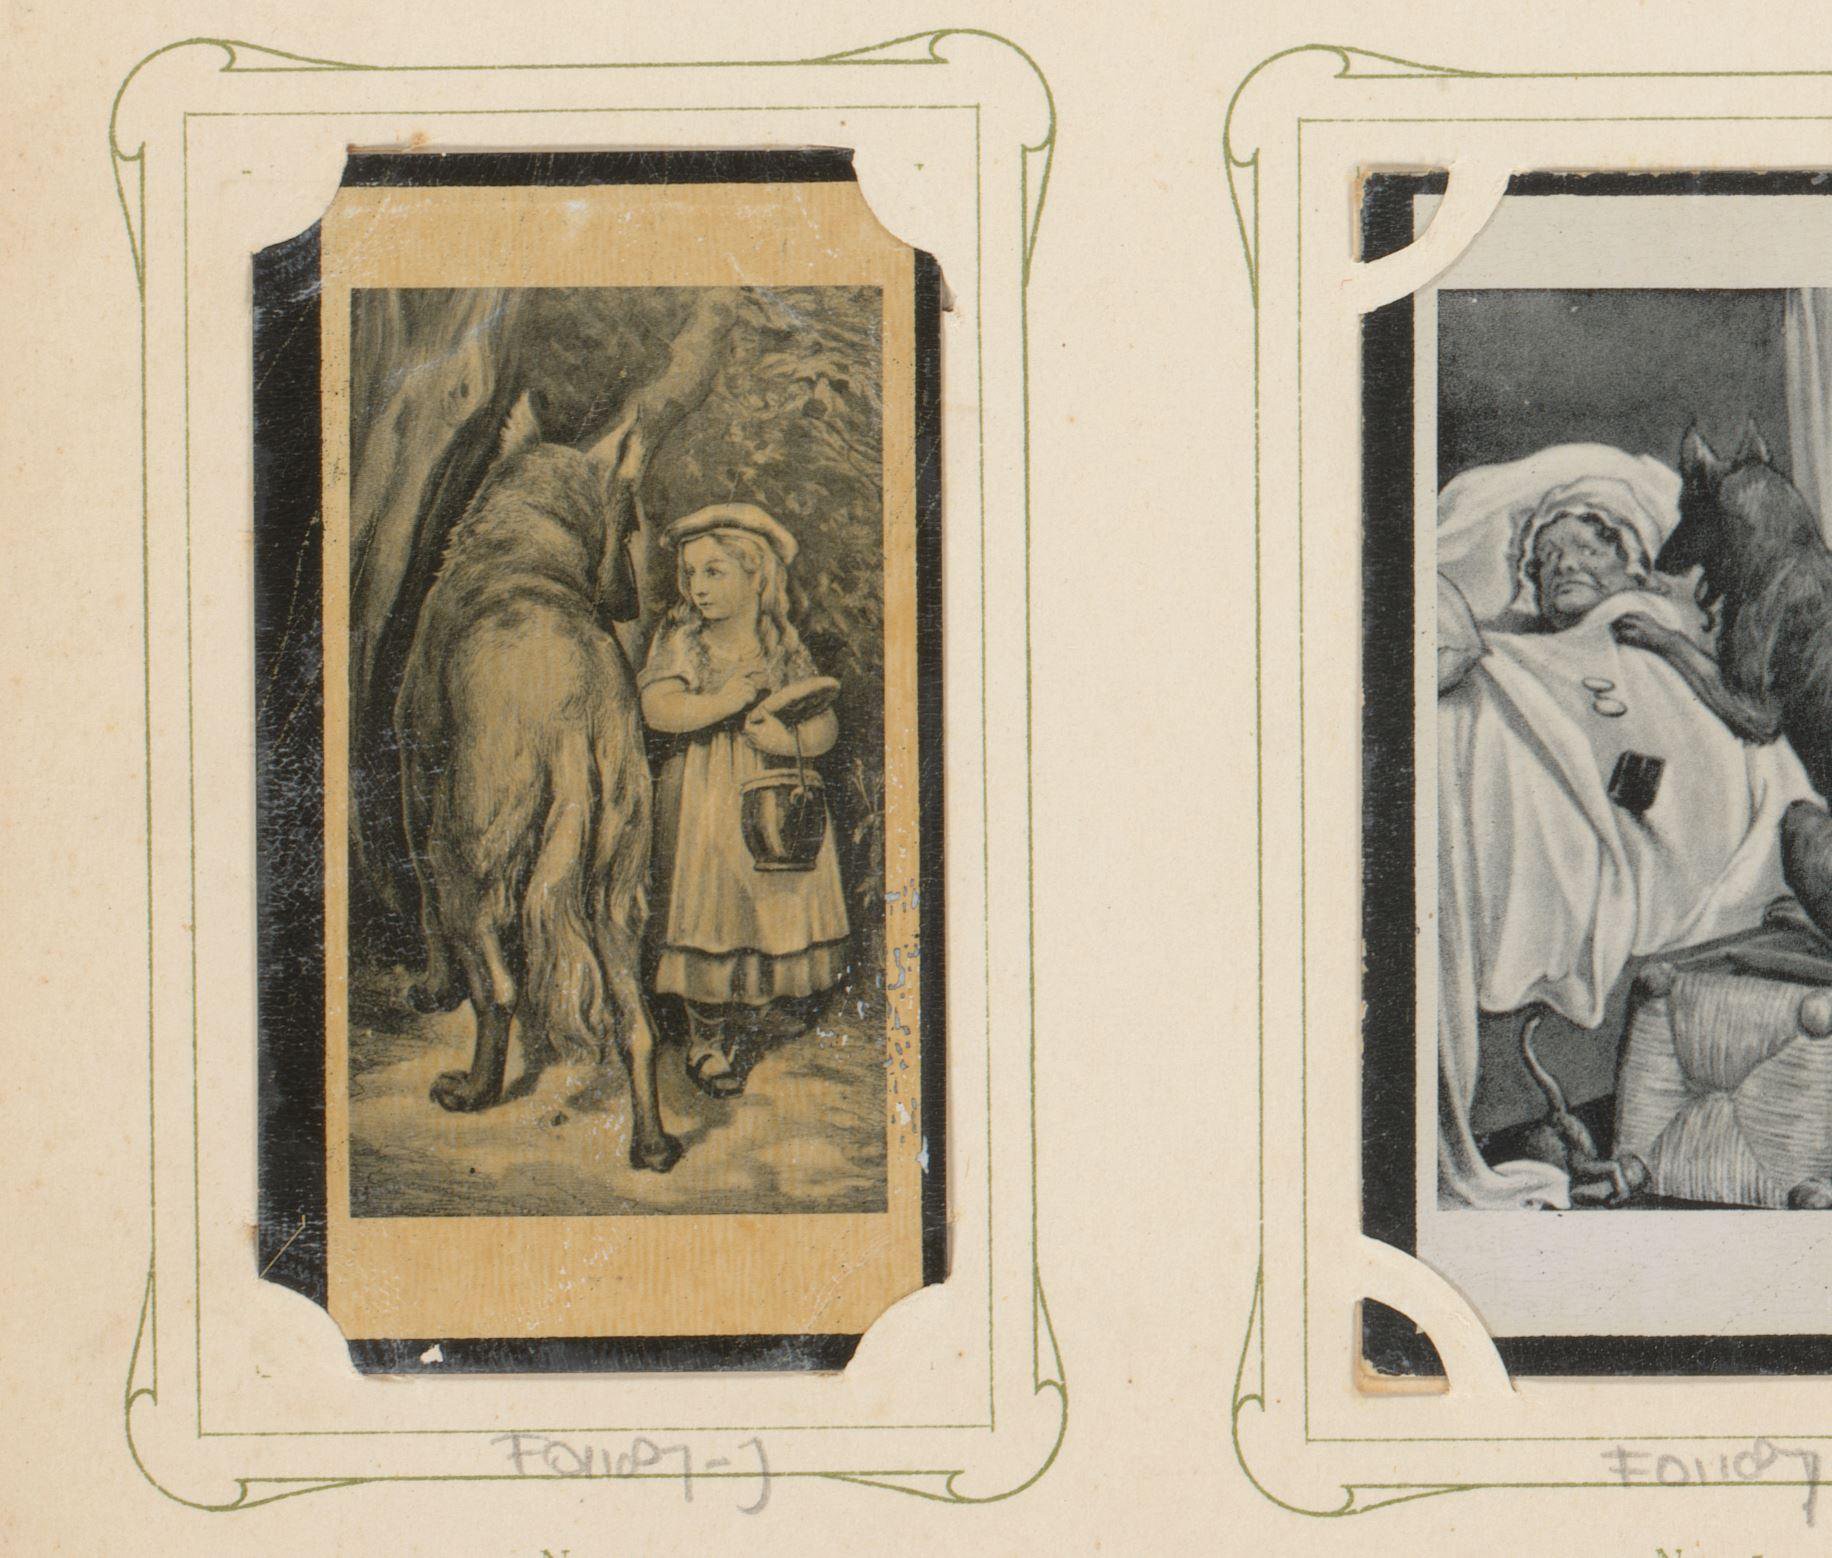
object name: photomechanical print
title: Reproductie van een tekening van Roodkapje die de wolf ontmoet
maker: Anonymous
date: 1905-1906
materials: paper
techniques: photograph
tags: girl (child between toddler and youth), tales and fairy tales: little red riding-hood, beasts of prey, predatory animals: wolf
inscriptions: inscription: ‘No. 4./ Roodkapje ontmoet den wolf.’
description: Deze prent maakt deel uit van een album.